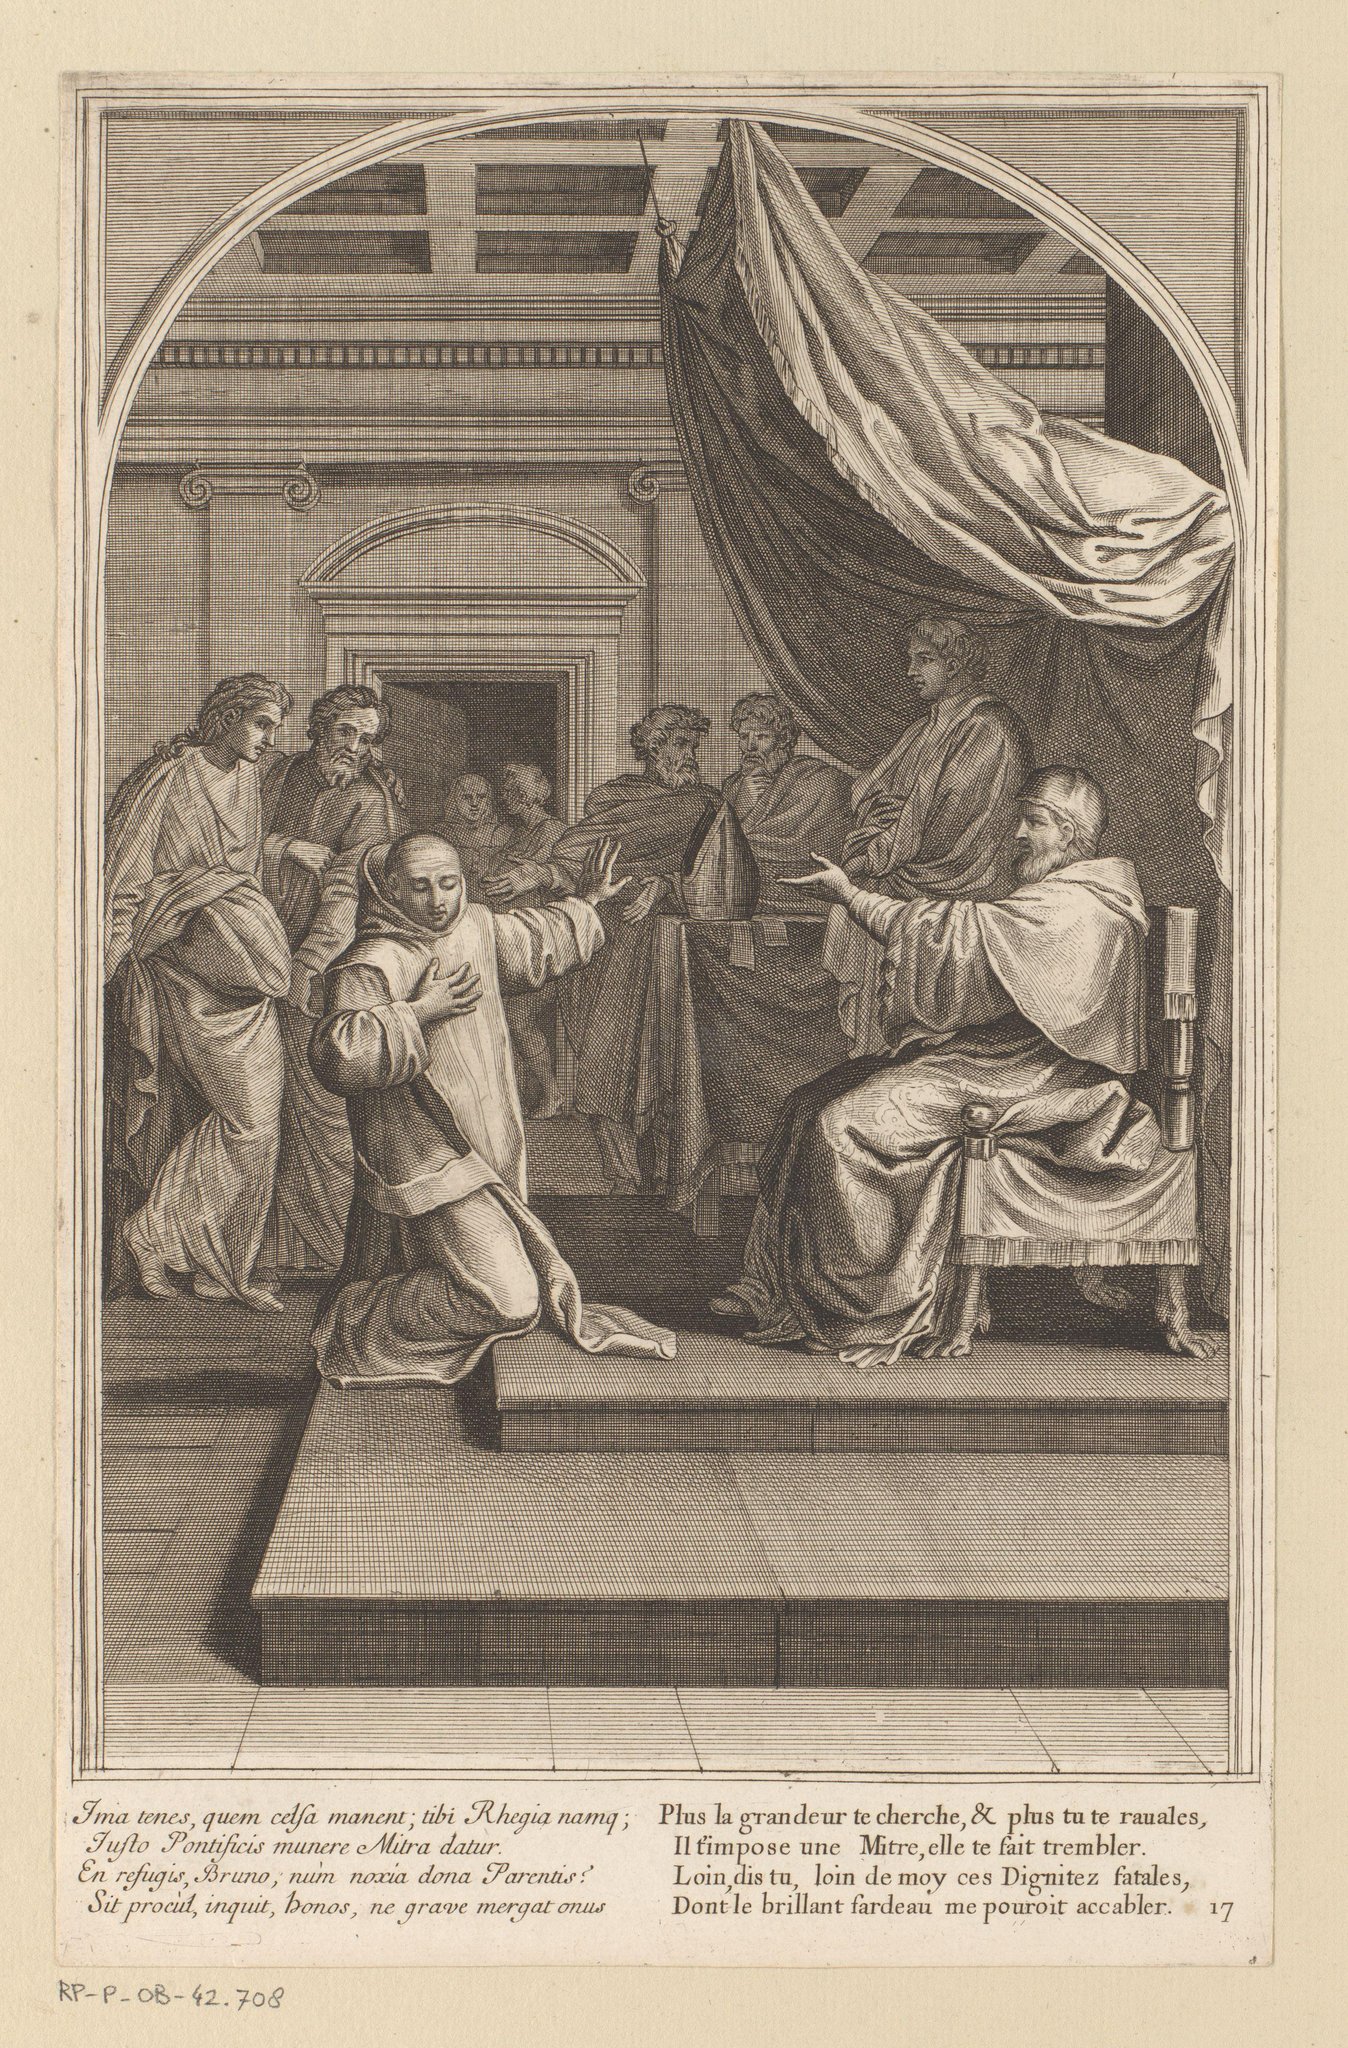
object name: print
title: La vie de St. Bruno (...)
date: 1623-1676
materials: paper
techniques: engraving, etching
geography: france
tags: rome, the founder of the order of the carthusians, bruno; possible attributes: cross, finger at lips, lily, mitre at his feet, olive-branch, ray of light, skull, (seven) star(s), historical persons, pope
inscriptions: collector's mark: Lugt 2165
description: Maakt deel uit van een serie met 24 prenten (inclusief twee titelprenten), naar schilderijen door Lesueur vervaardigd tussen 1645-1648 voor de Chartreuse de Paris. De serie is getiteld: La vie de St. Bruno fondateur de l'Ordre des Chartreux peinte au cloistre de la Chartreuse de Paris par Eustache Le Sueur.